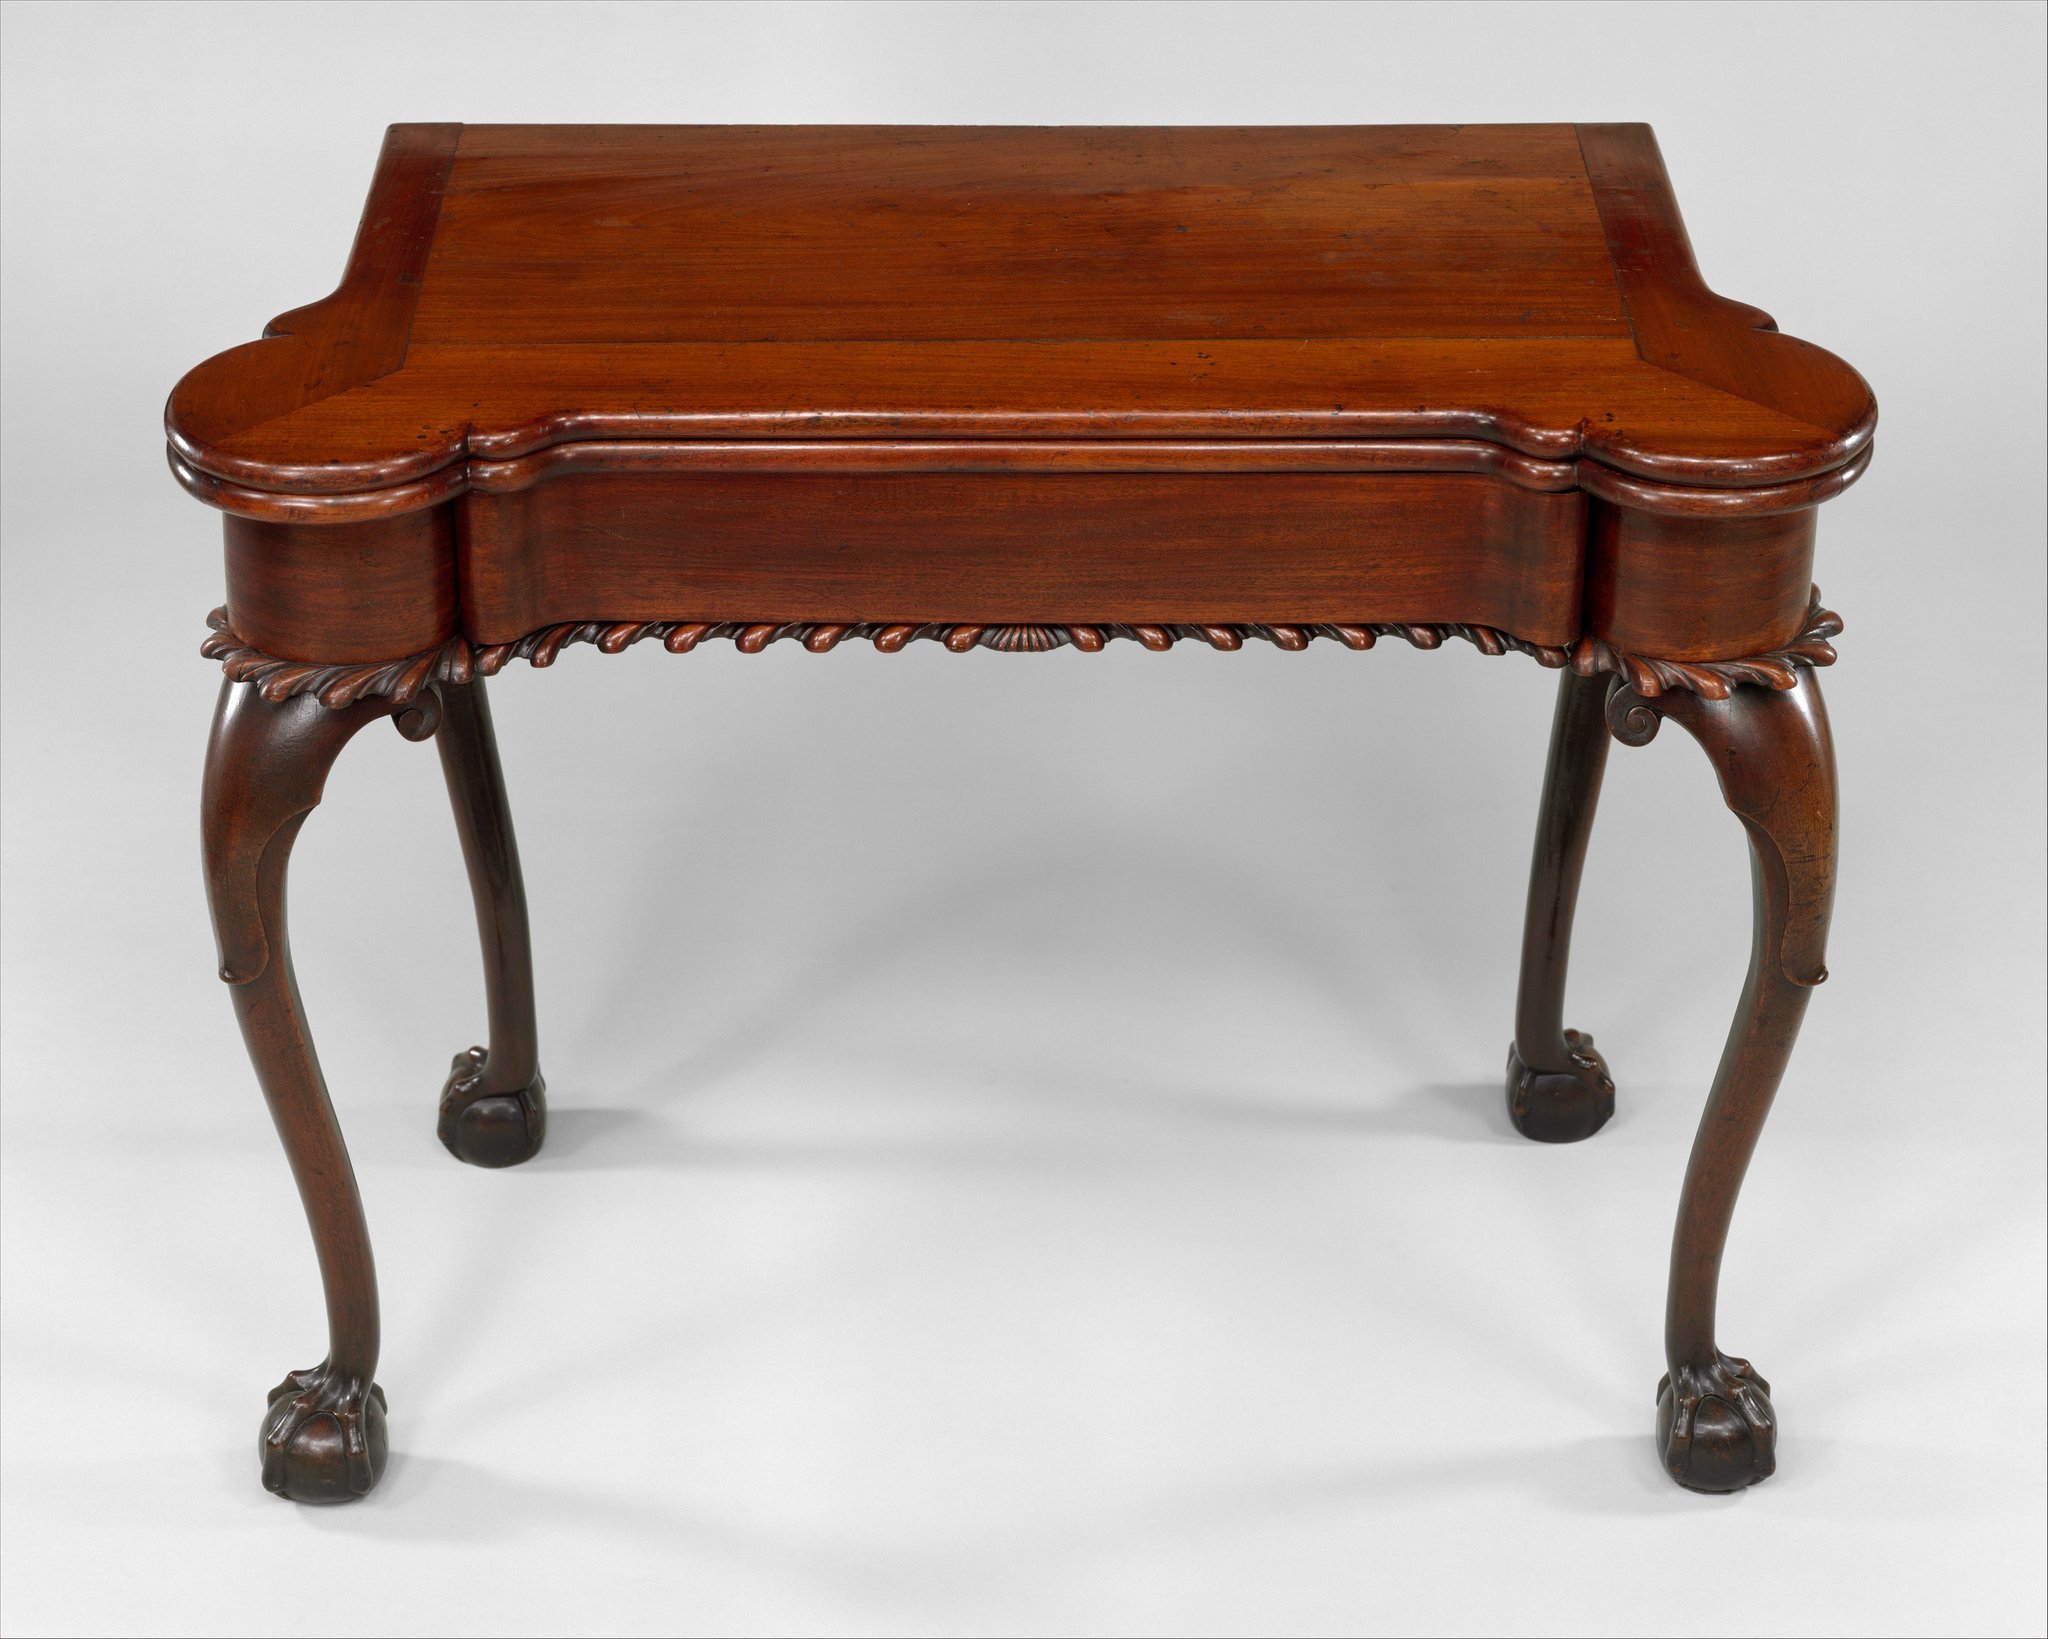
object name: card table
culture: american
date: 1765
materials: wood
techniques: veneering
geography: united states